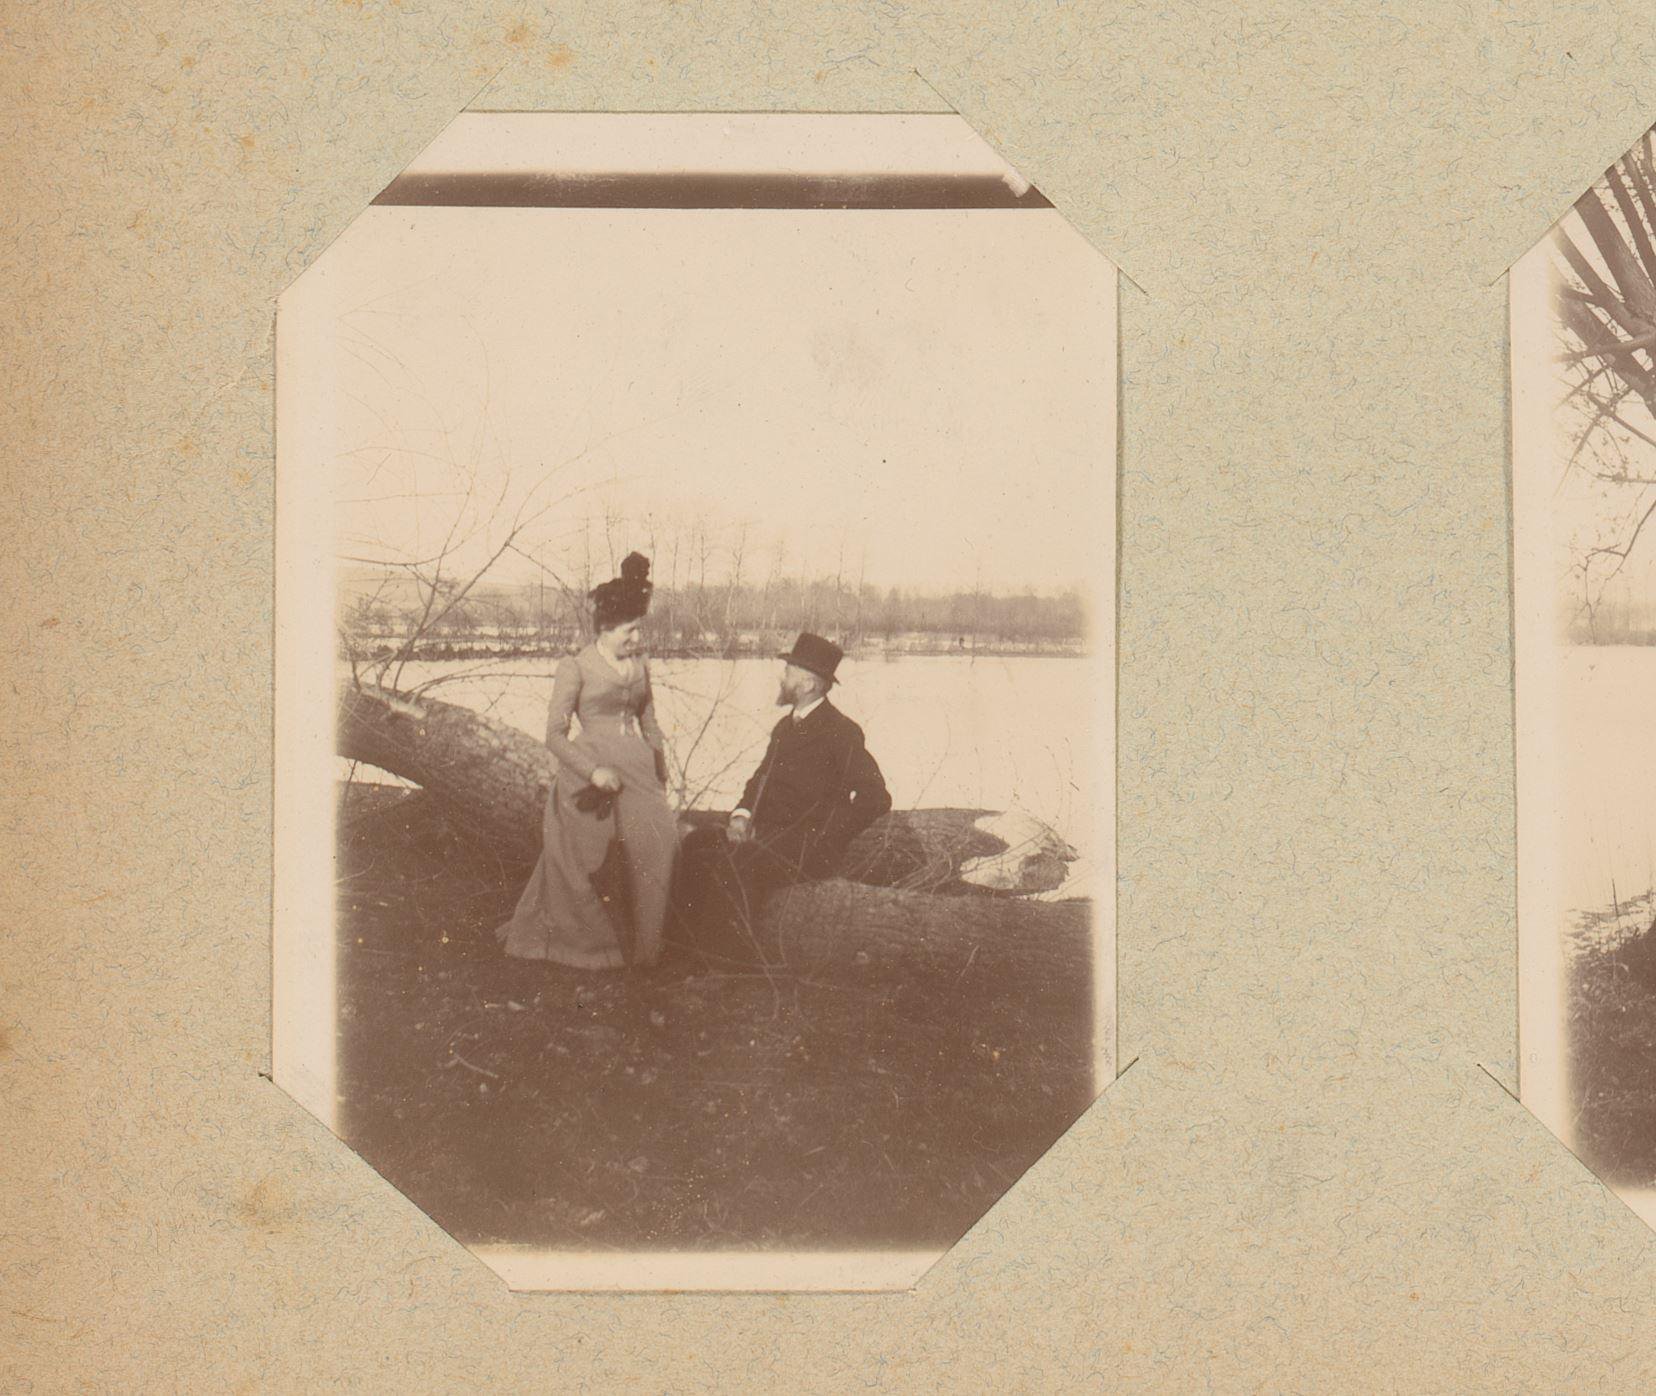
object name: photograph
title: Man en een vrouw bij gevelde bomen langs een rivier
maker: Anonymous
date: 1897-1900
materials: paper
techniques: gelatin silver print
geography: france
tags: adult woman, adult man, france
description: Over de foto is een ander negatief afgedrukt van een voorstelling van bomen.